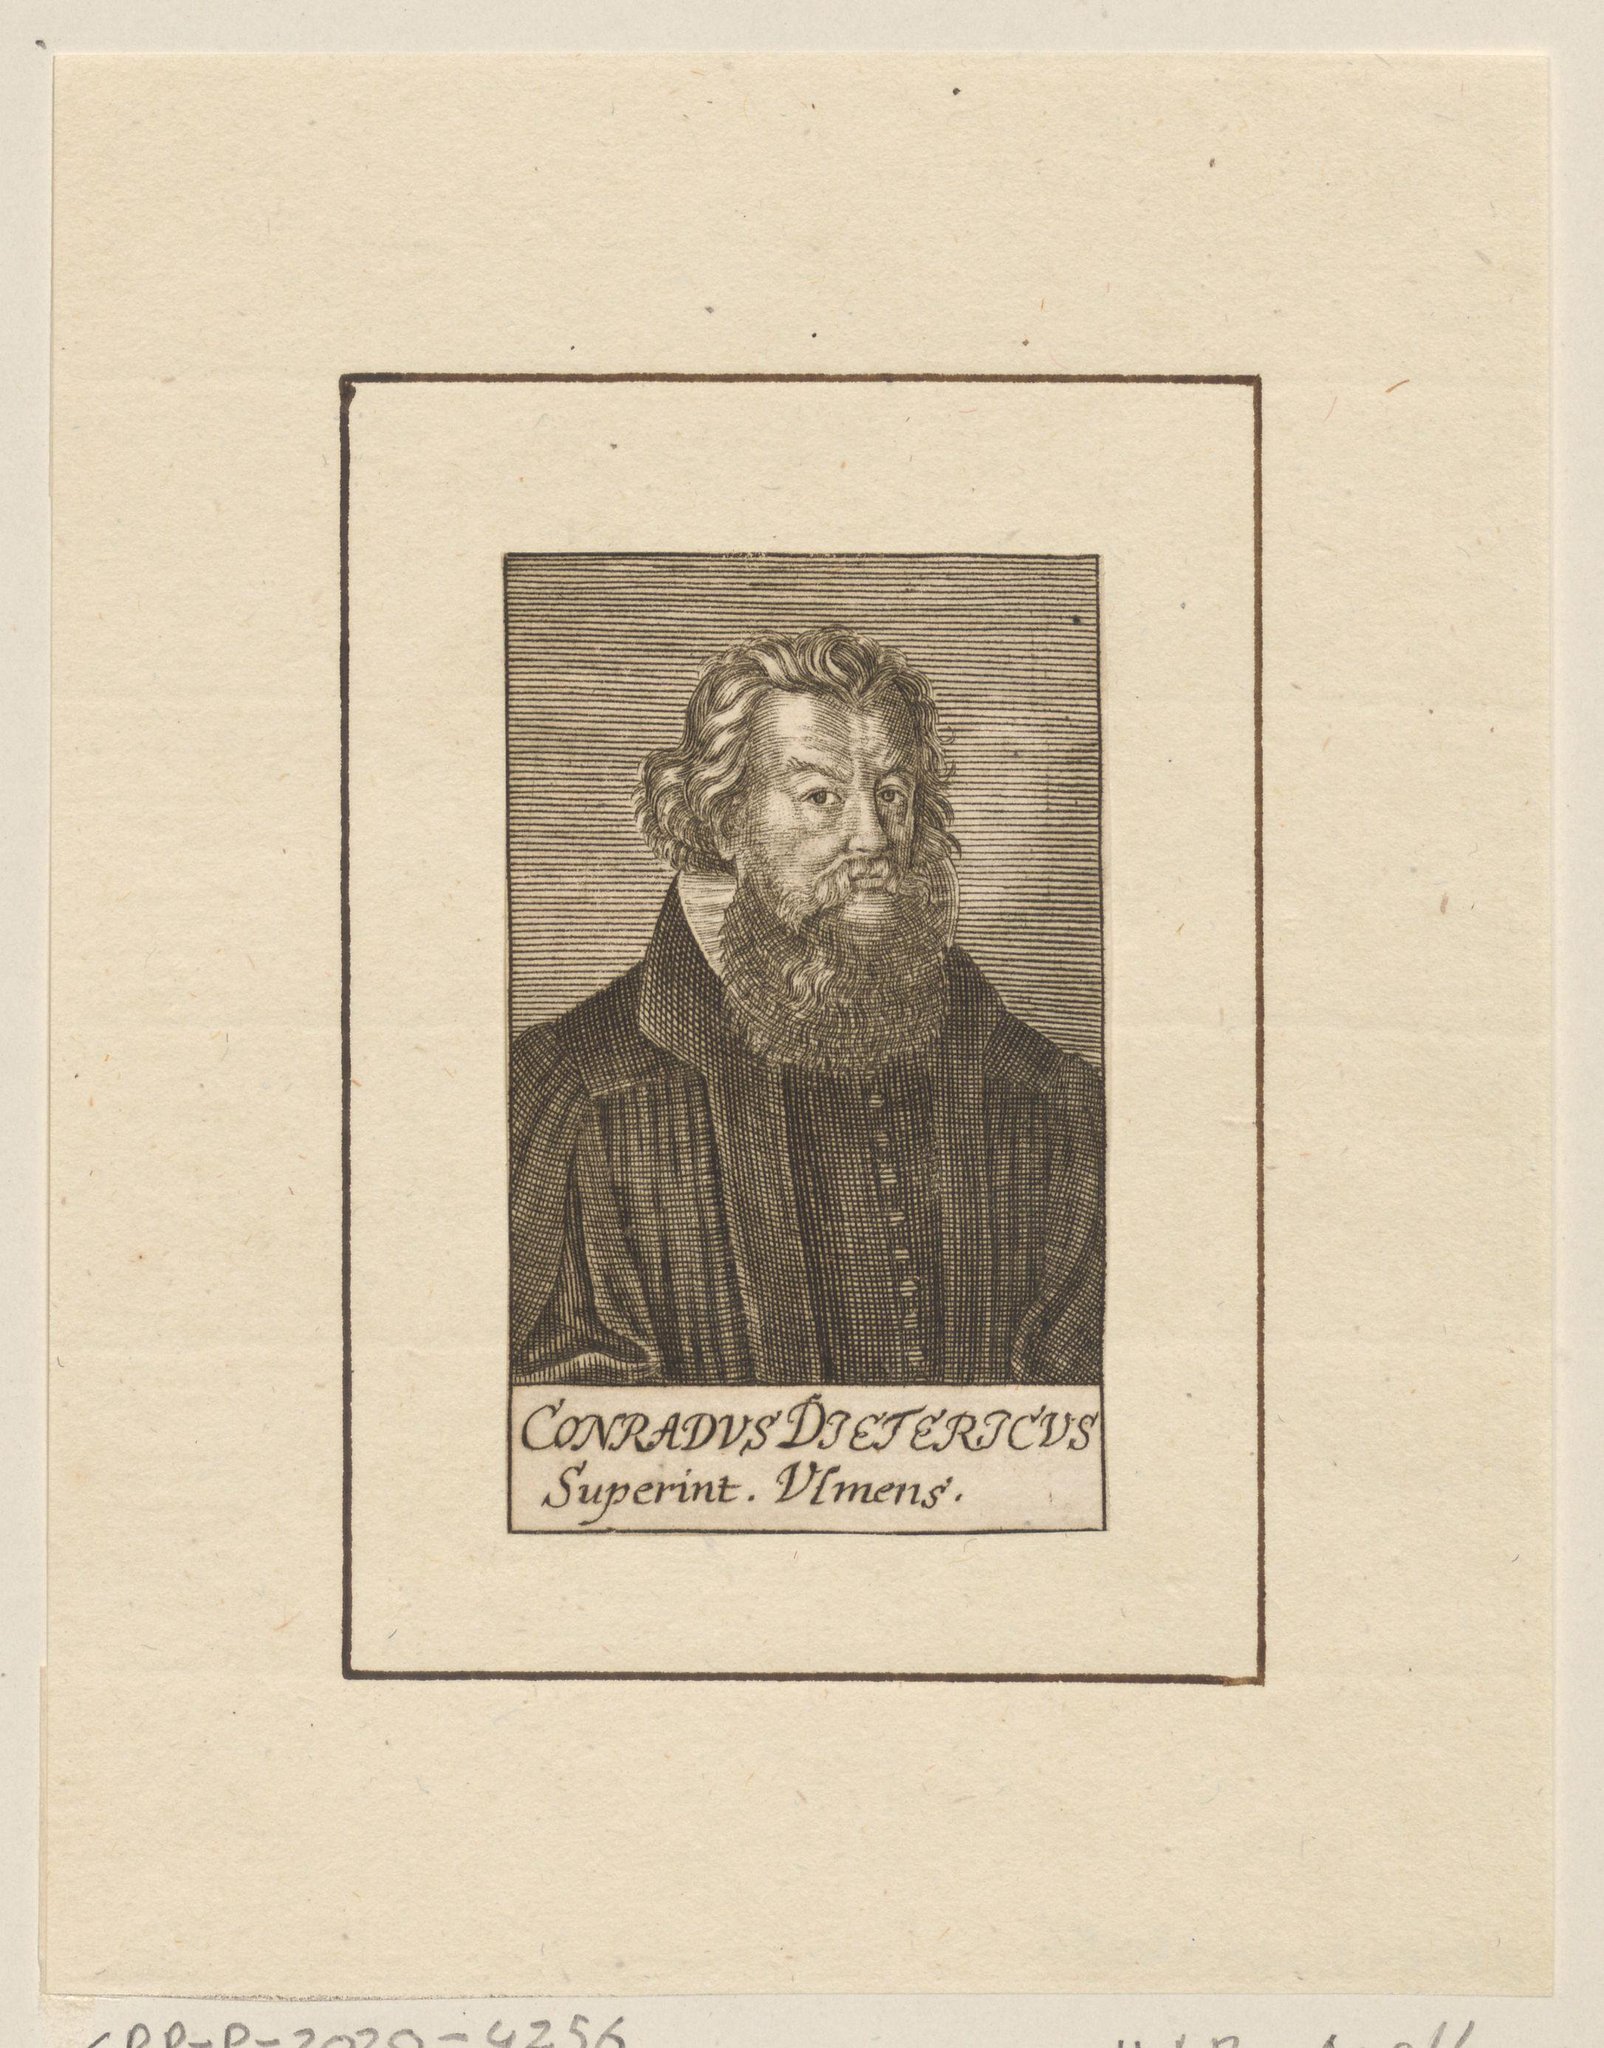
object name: print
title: Portret van Konrad Dieterich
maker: johann azelt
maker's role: print maker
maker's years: 1654-1692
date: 1688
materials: paper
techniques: engraving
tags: theologian, historical persons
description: Prent maakt deel uit van een grotere prent die later is verknipt. Prent waarschijnlijk uit: Freher, Paul. Theatrum virorum eruditione clarorum. Neurenberg: Johann Hoffmann, 1688.